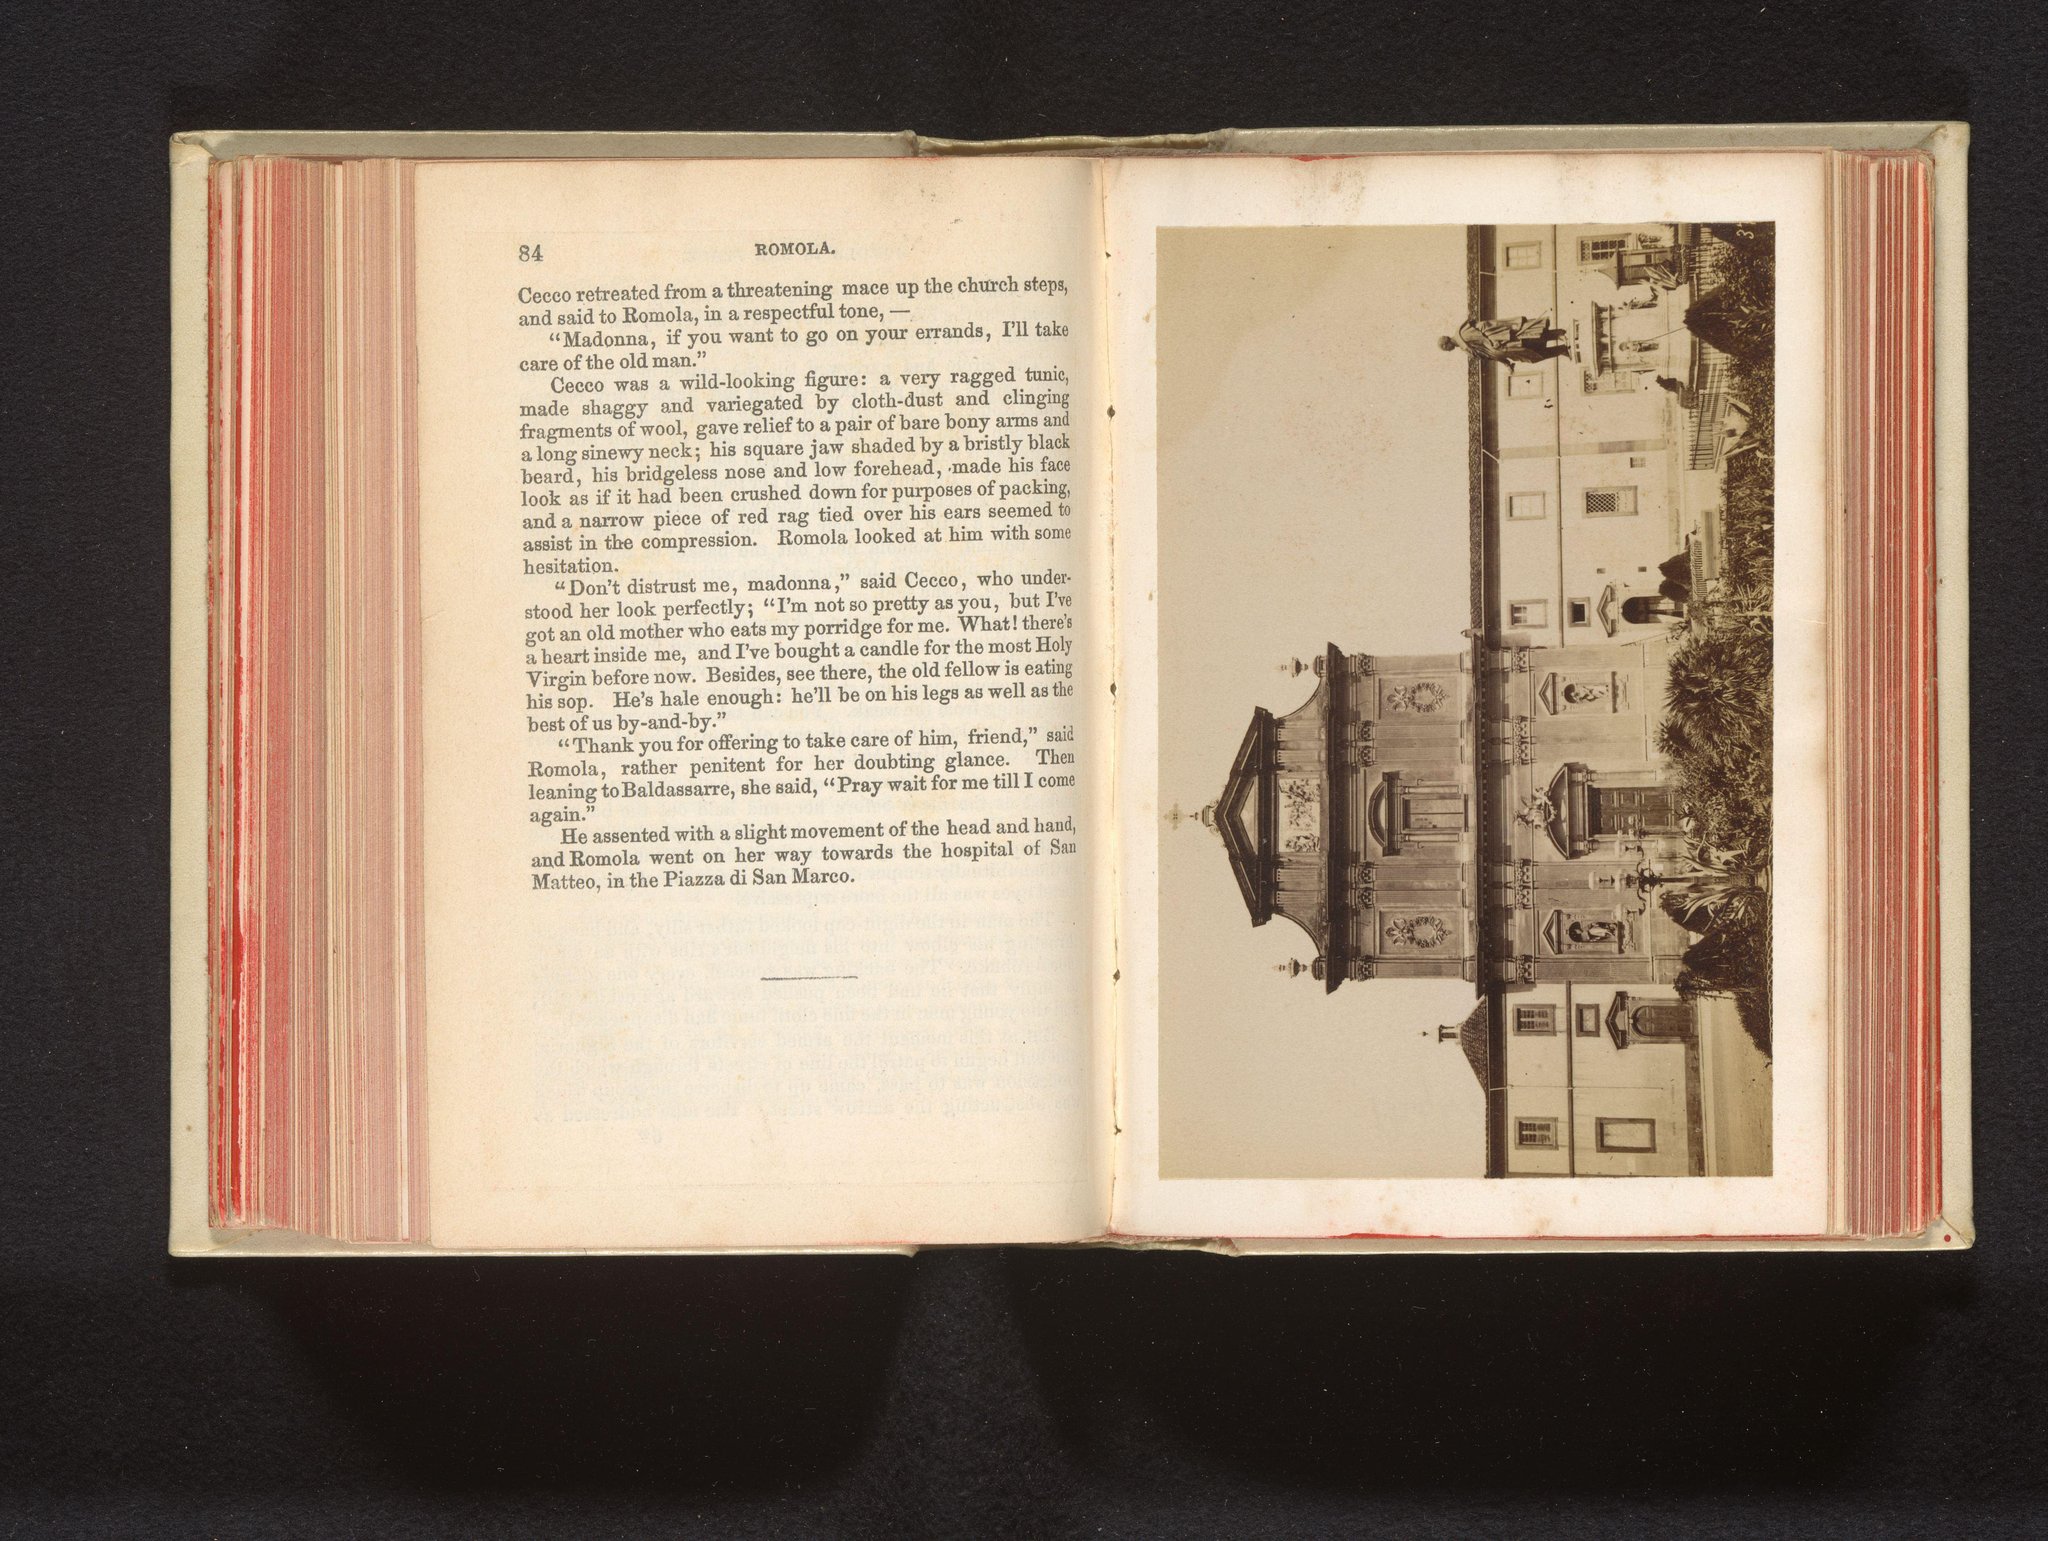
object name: photograph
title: Gezicht op het San Marco-klooster te Florence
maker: Anonymous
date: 1858-1863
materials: photographic support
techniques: albumen print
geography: florence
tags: church (exterior), façade (of house or building)